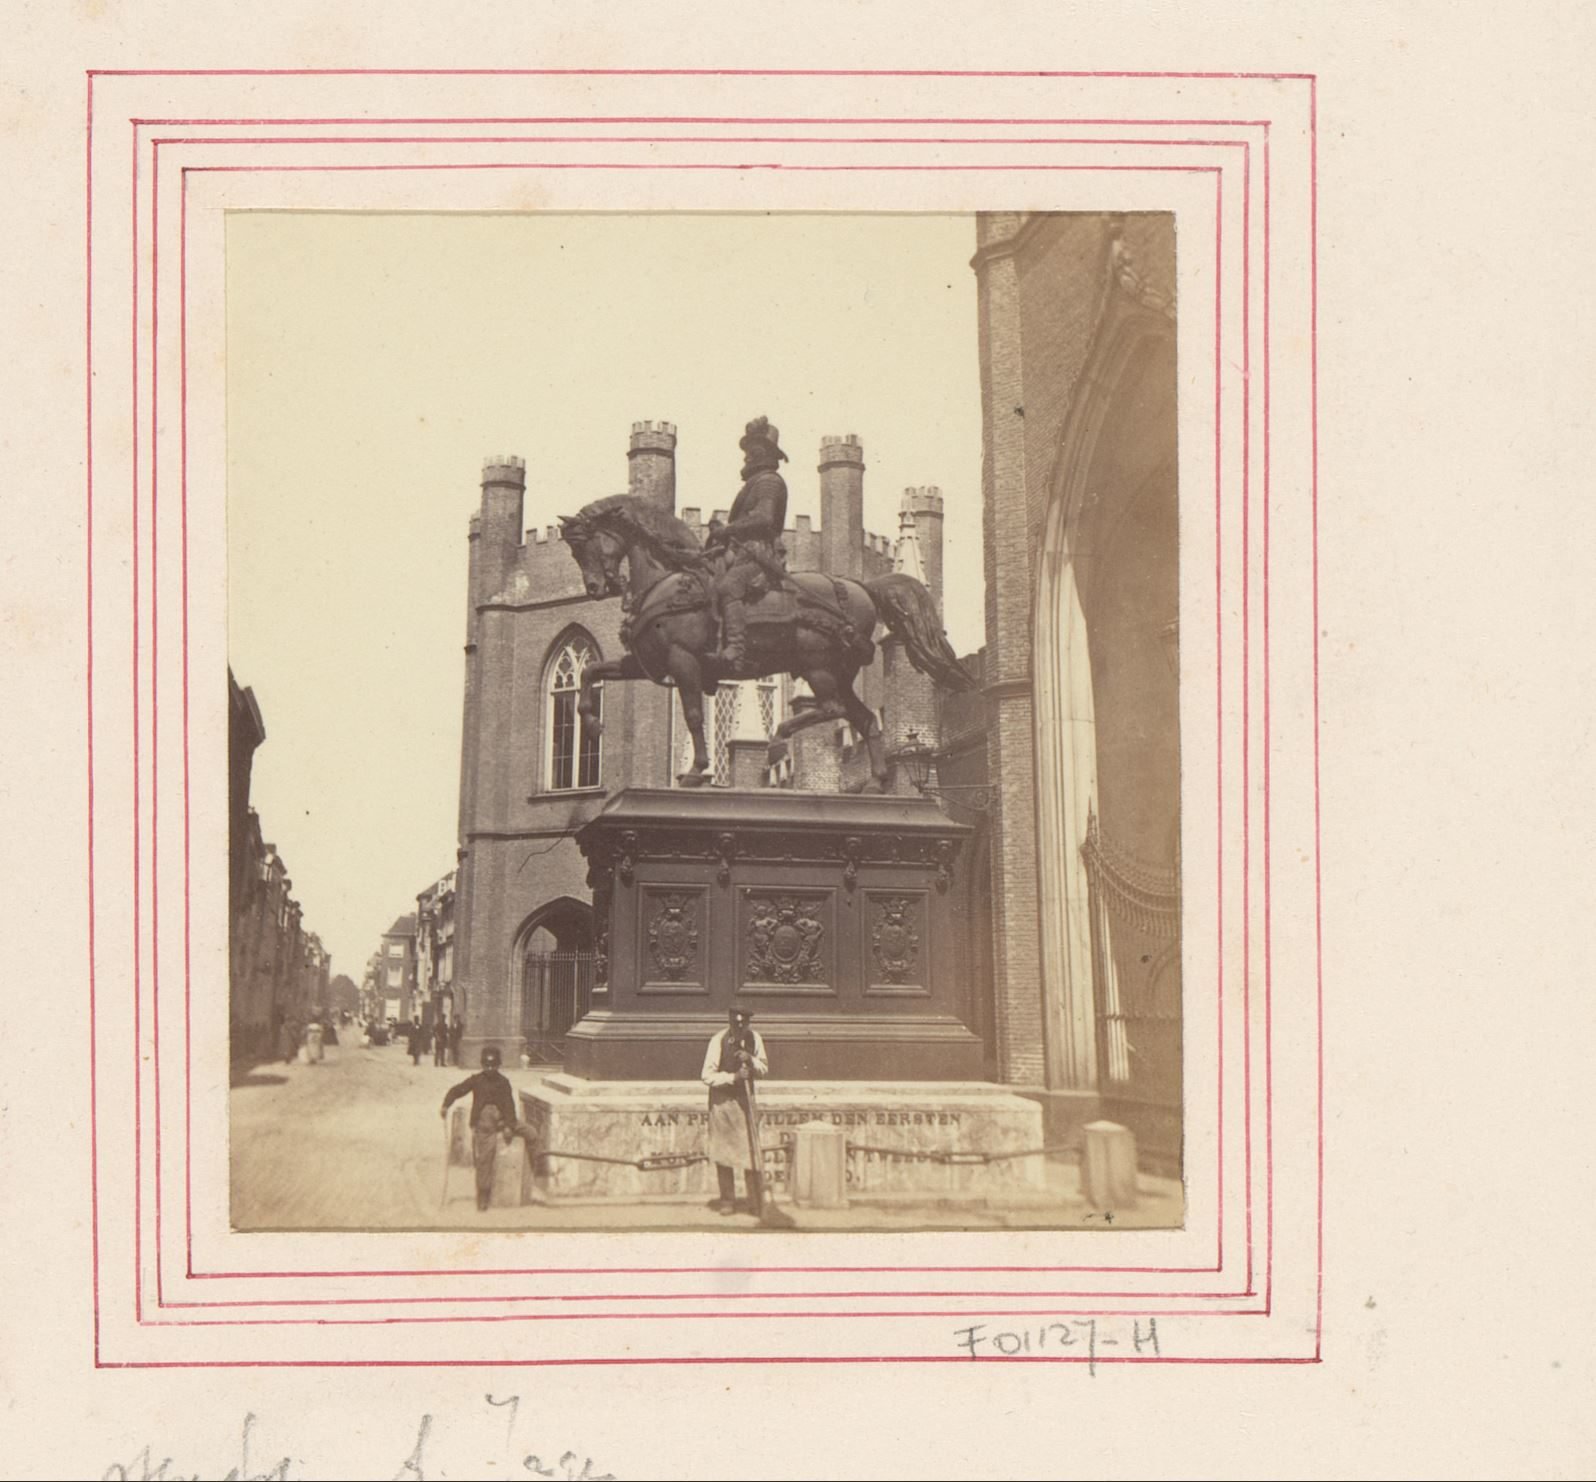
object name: photograph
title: Standbeeld van Willem van Oranje aan het Noordeinde in Den Haag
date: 1870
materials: photographic support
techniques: albumen print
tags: william i (prince of orange), monument, statue, street (+ city(-scape) with figures, staffage)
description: Onderdeel van Album met foto's en litho's van bezienswaardigheden in Noord- en Zuid-Hollandse steden, schilderijen en klederdrachten.